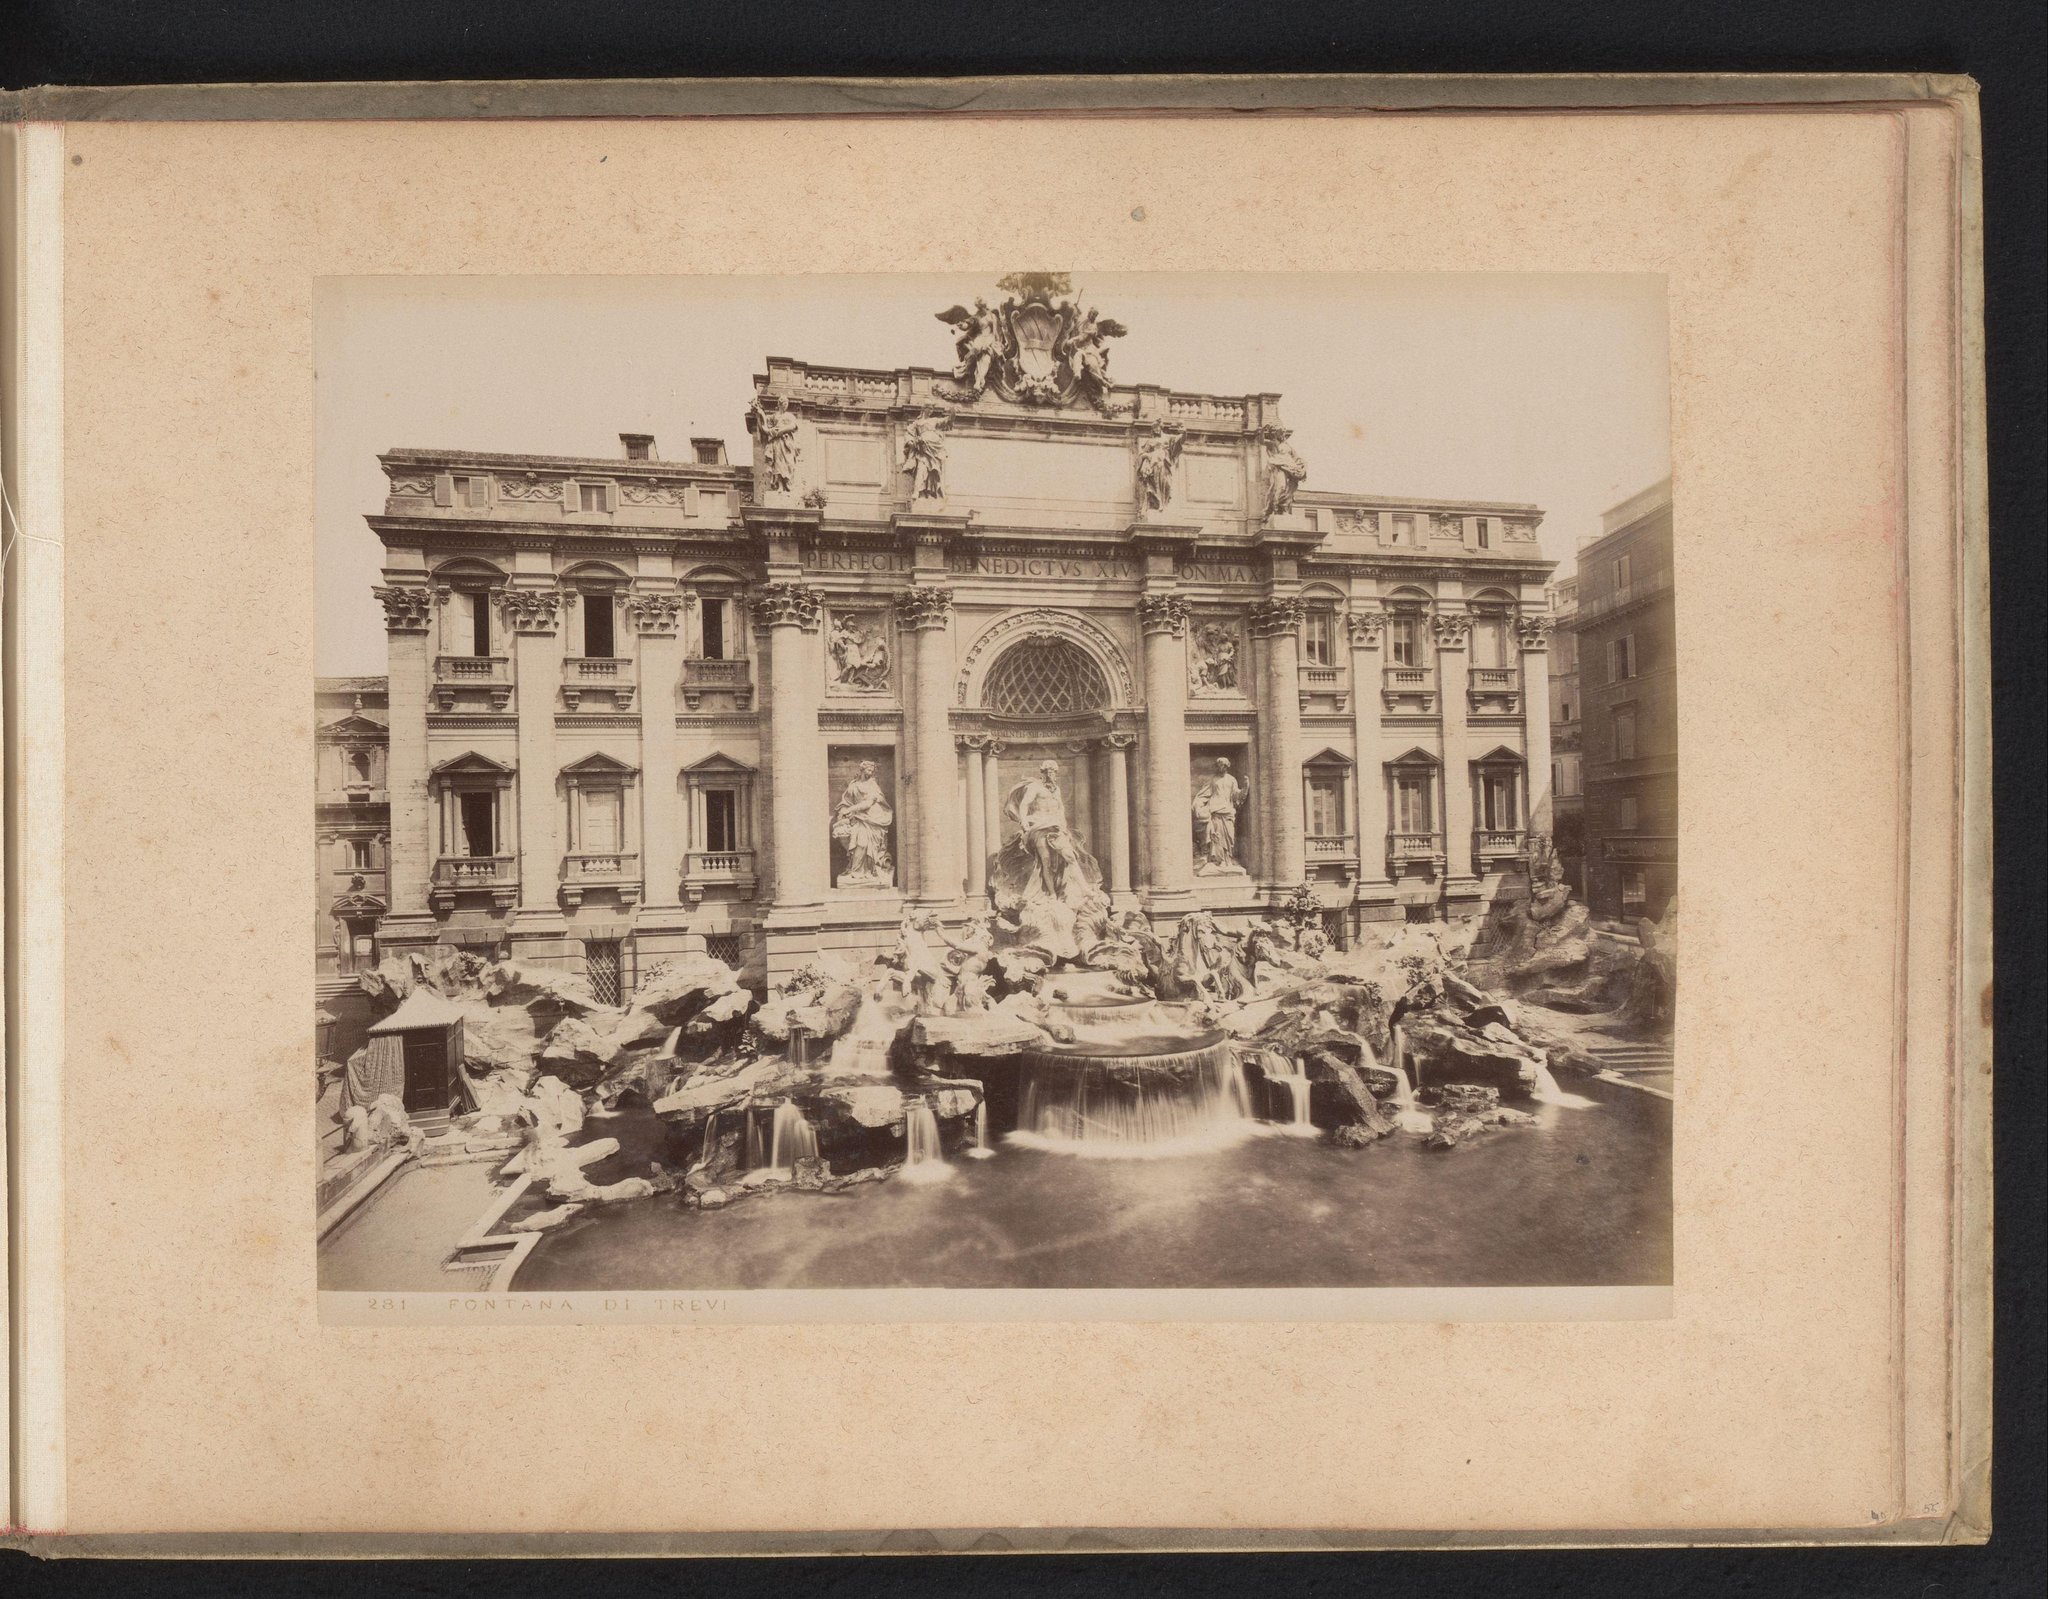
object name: album leaf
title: Gezicht op de Trevifontein in Rome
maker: Anonymous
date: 1870-1895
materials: cardboard, photographic support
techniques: albumen print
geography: rome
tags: ornamental fountain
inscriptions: inscription: ‘281 FONTANA DI TREVI’